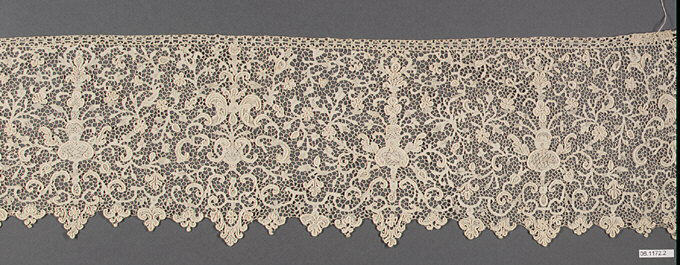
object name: flounce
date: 1701-1733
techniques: lace